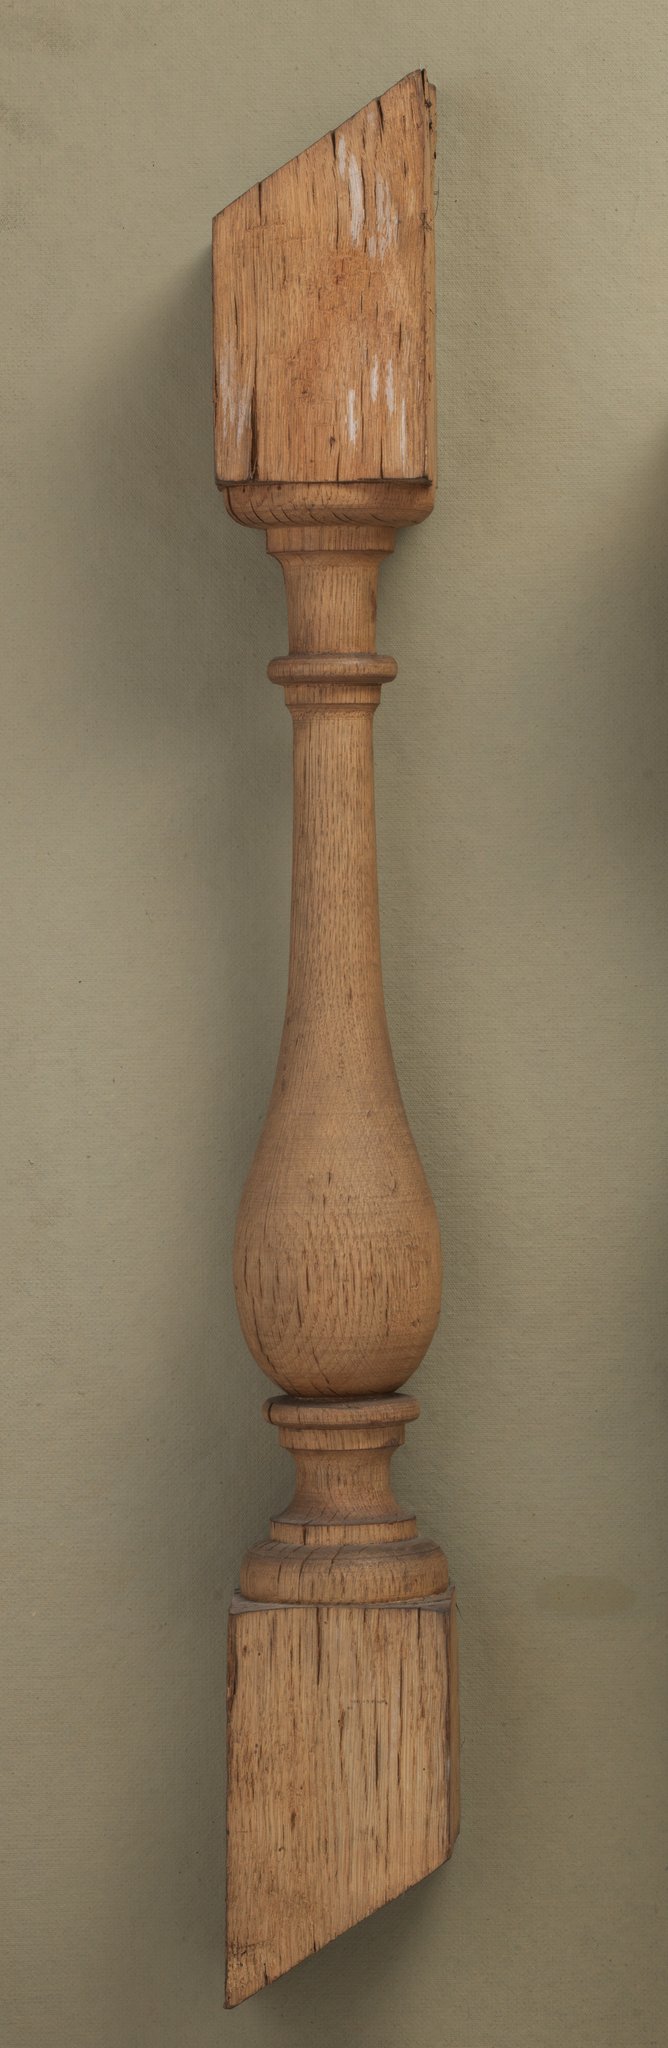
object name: baluster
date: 1667-1733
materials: wood